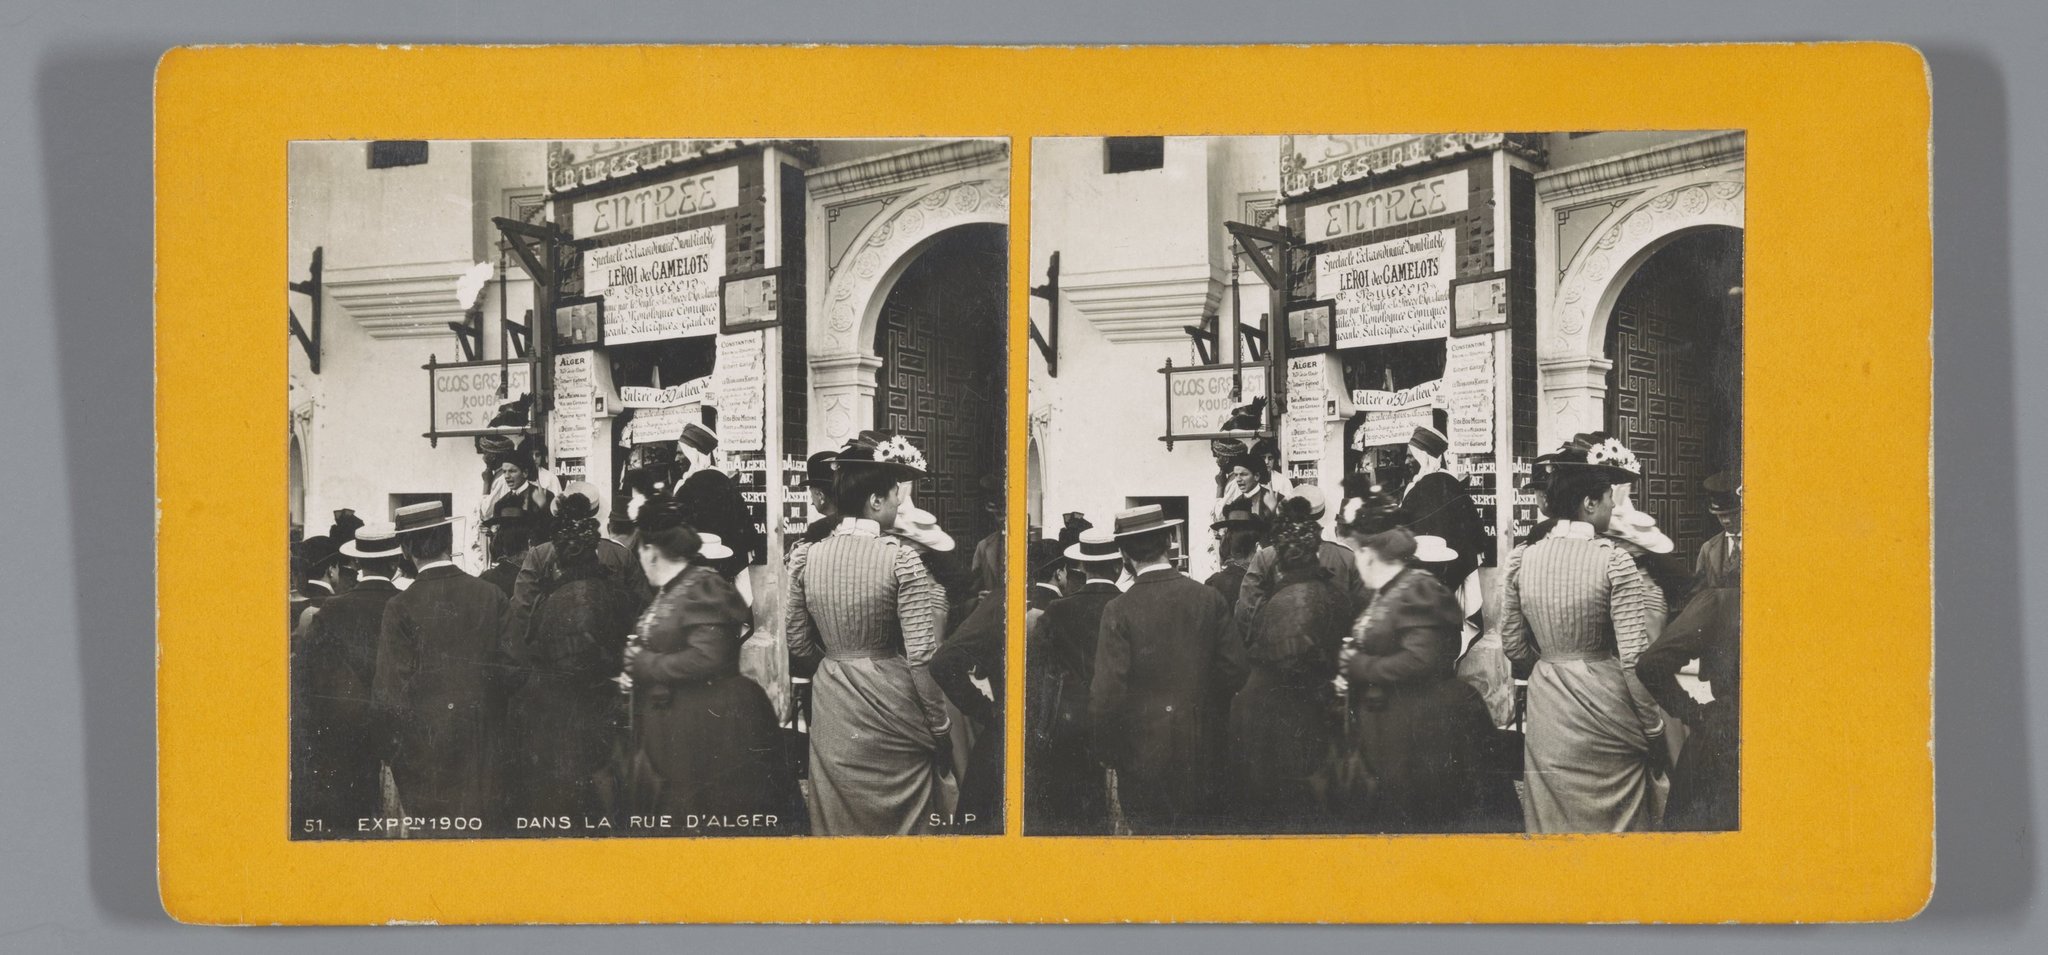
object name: stereograph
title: Expon 1900. Dans le Rue d'Alger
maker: Anonymous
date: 1900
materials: paper, cardboard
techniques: gelatin silver print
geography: paris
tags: world fair, world exhibition, market, paris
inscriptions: number: ‘51.’